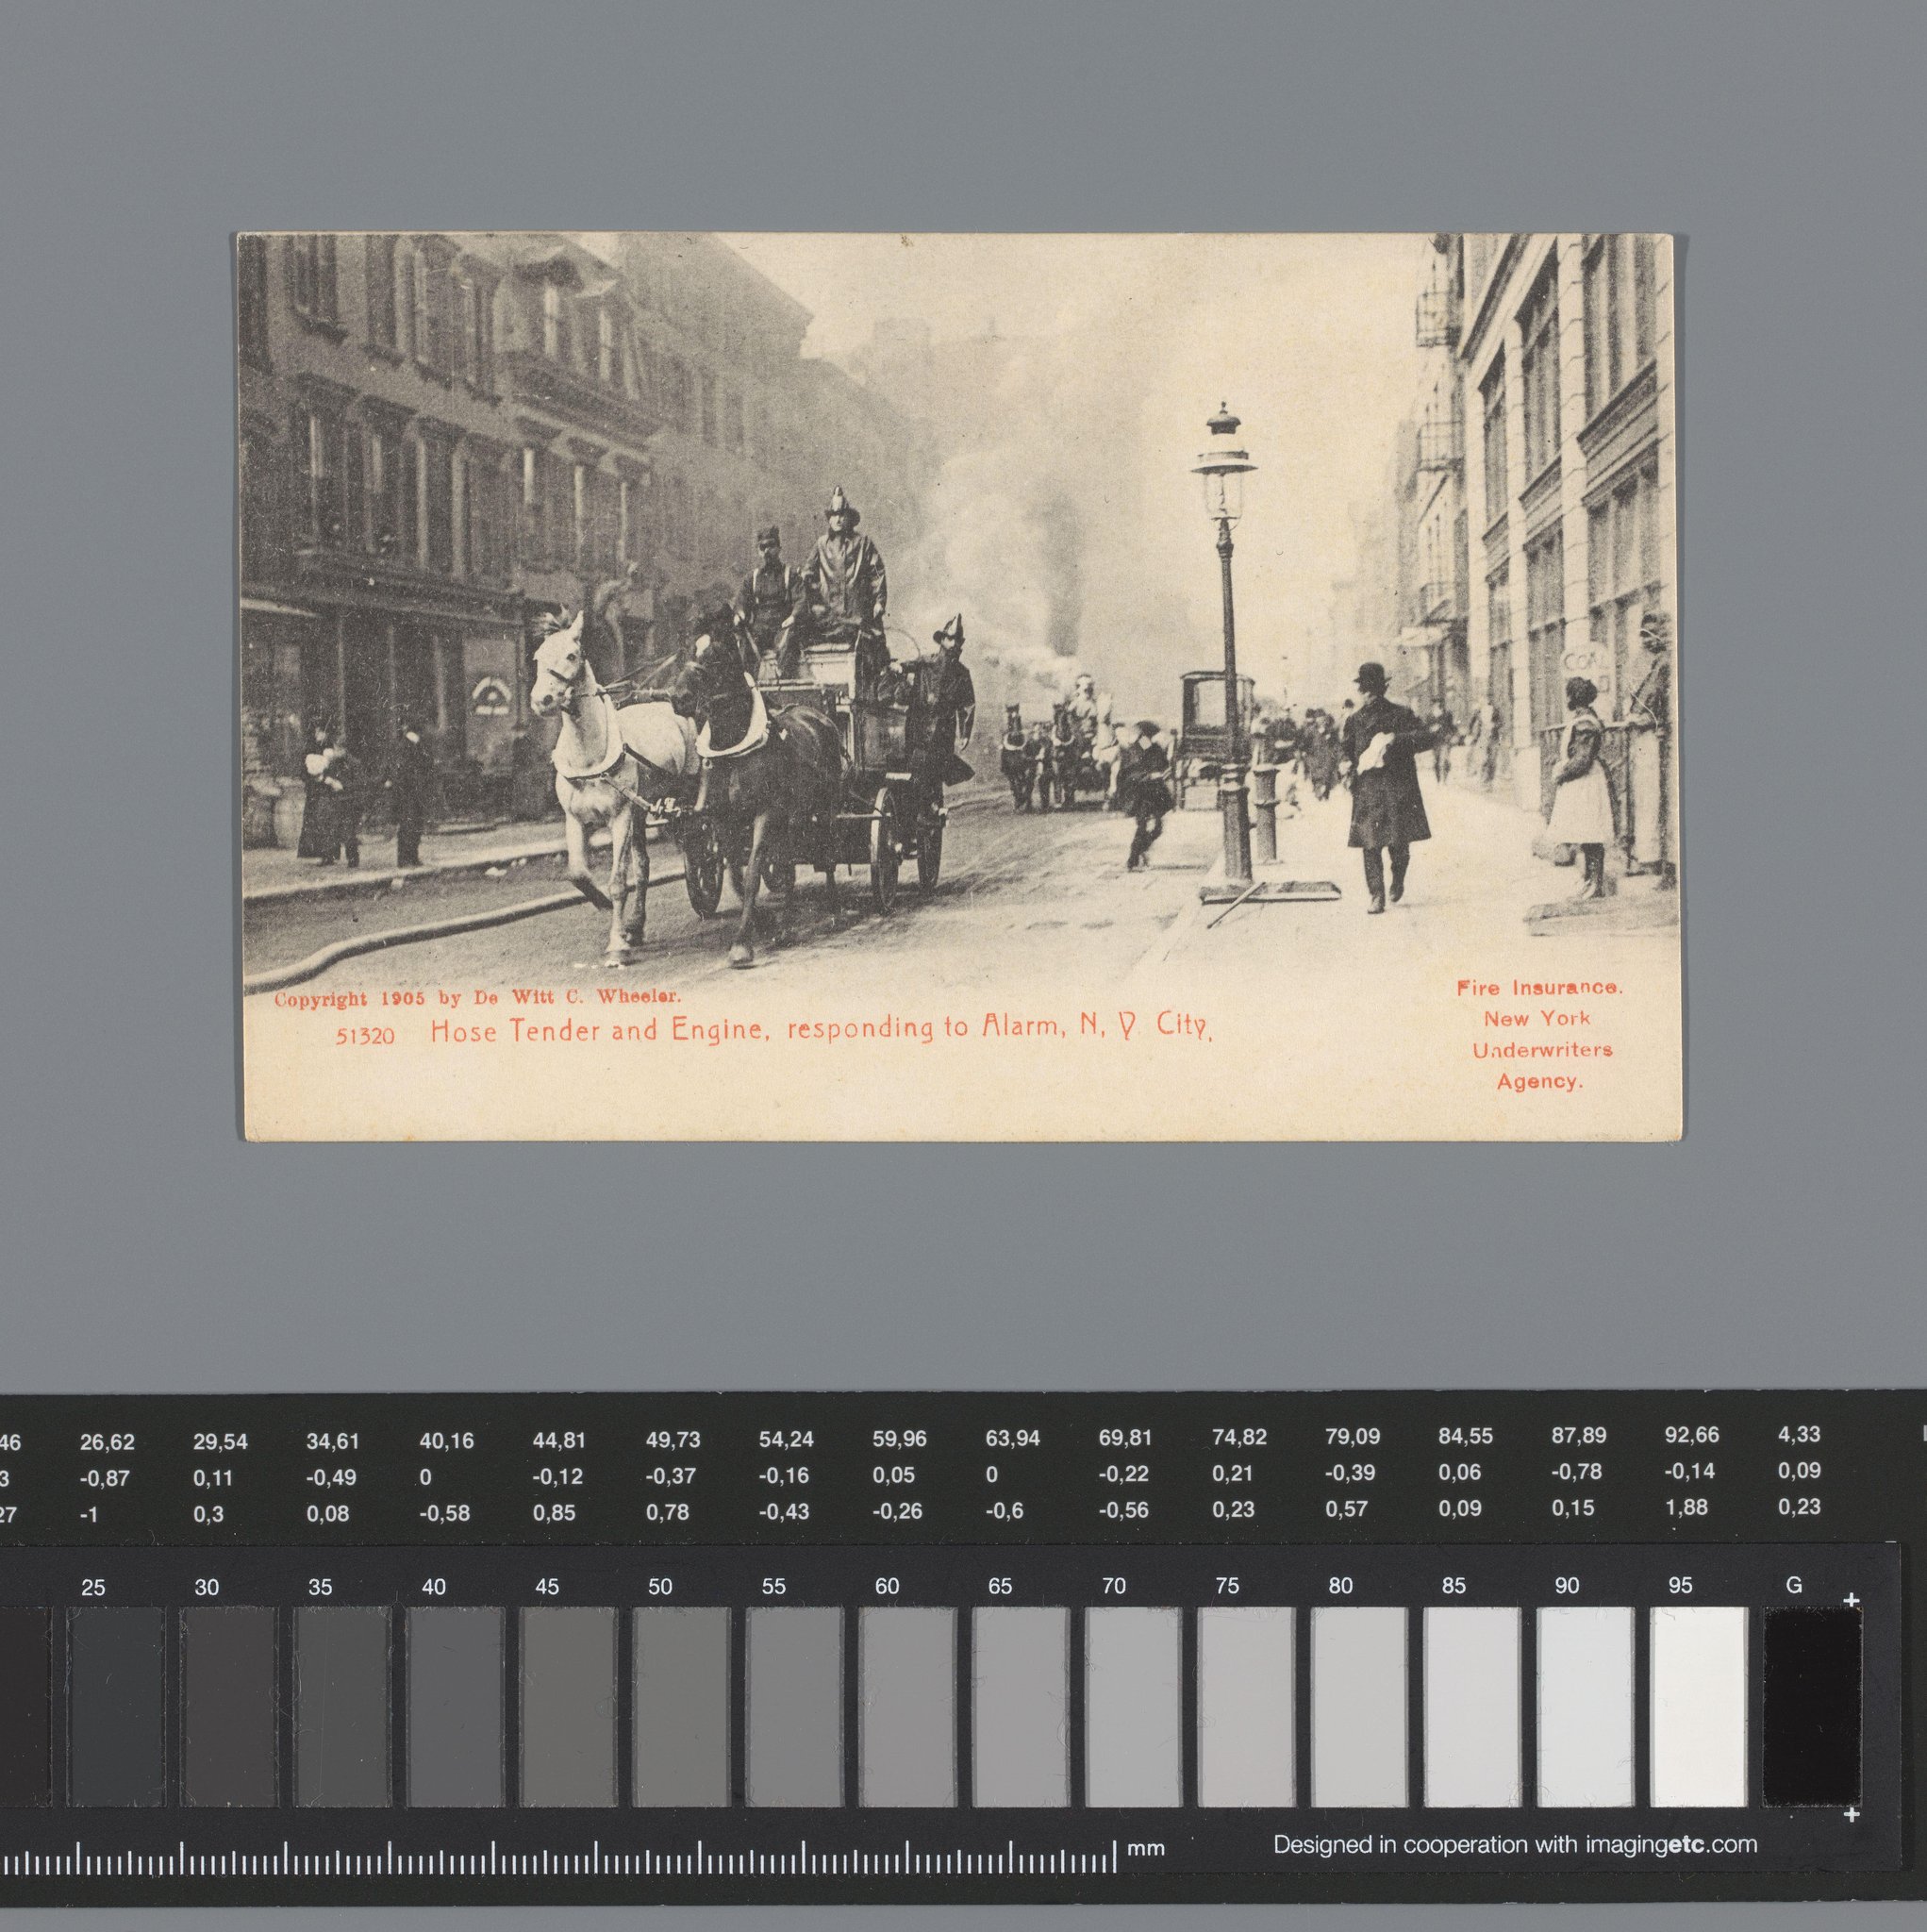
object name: ansichtkaart, prentbriefkaart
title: Reclame voor de Fire Insurance New York Underwriters Agency met een foto van het uitrukken van de brandweer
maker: dewitt c. wheeler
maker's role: fotograaf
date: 1905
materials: photographic support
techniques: photograph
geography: united states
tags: new york (city)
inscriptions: inscription: ‘The Rotograph Co., N.Y., City. (Germany.)’, inscription: ‘Fire Insurance / New York / Underwriters / Agency.’, inscription: ‘Copyright 1905 by De Witt C. Wheeler / 51320 Hose Tender and Engine, responding to Alarm, N Y, City.’